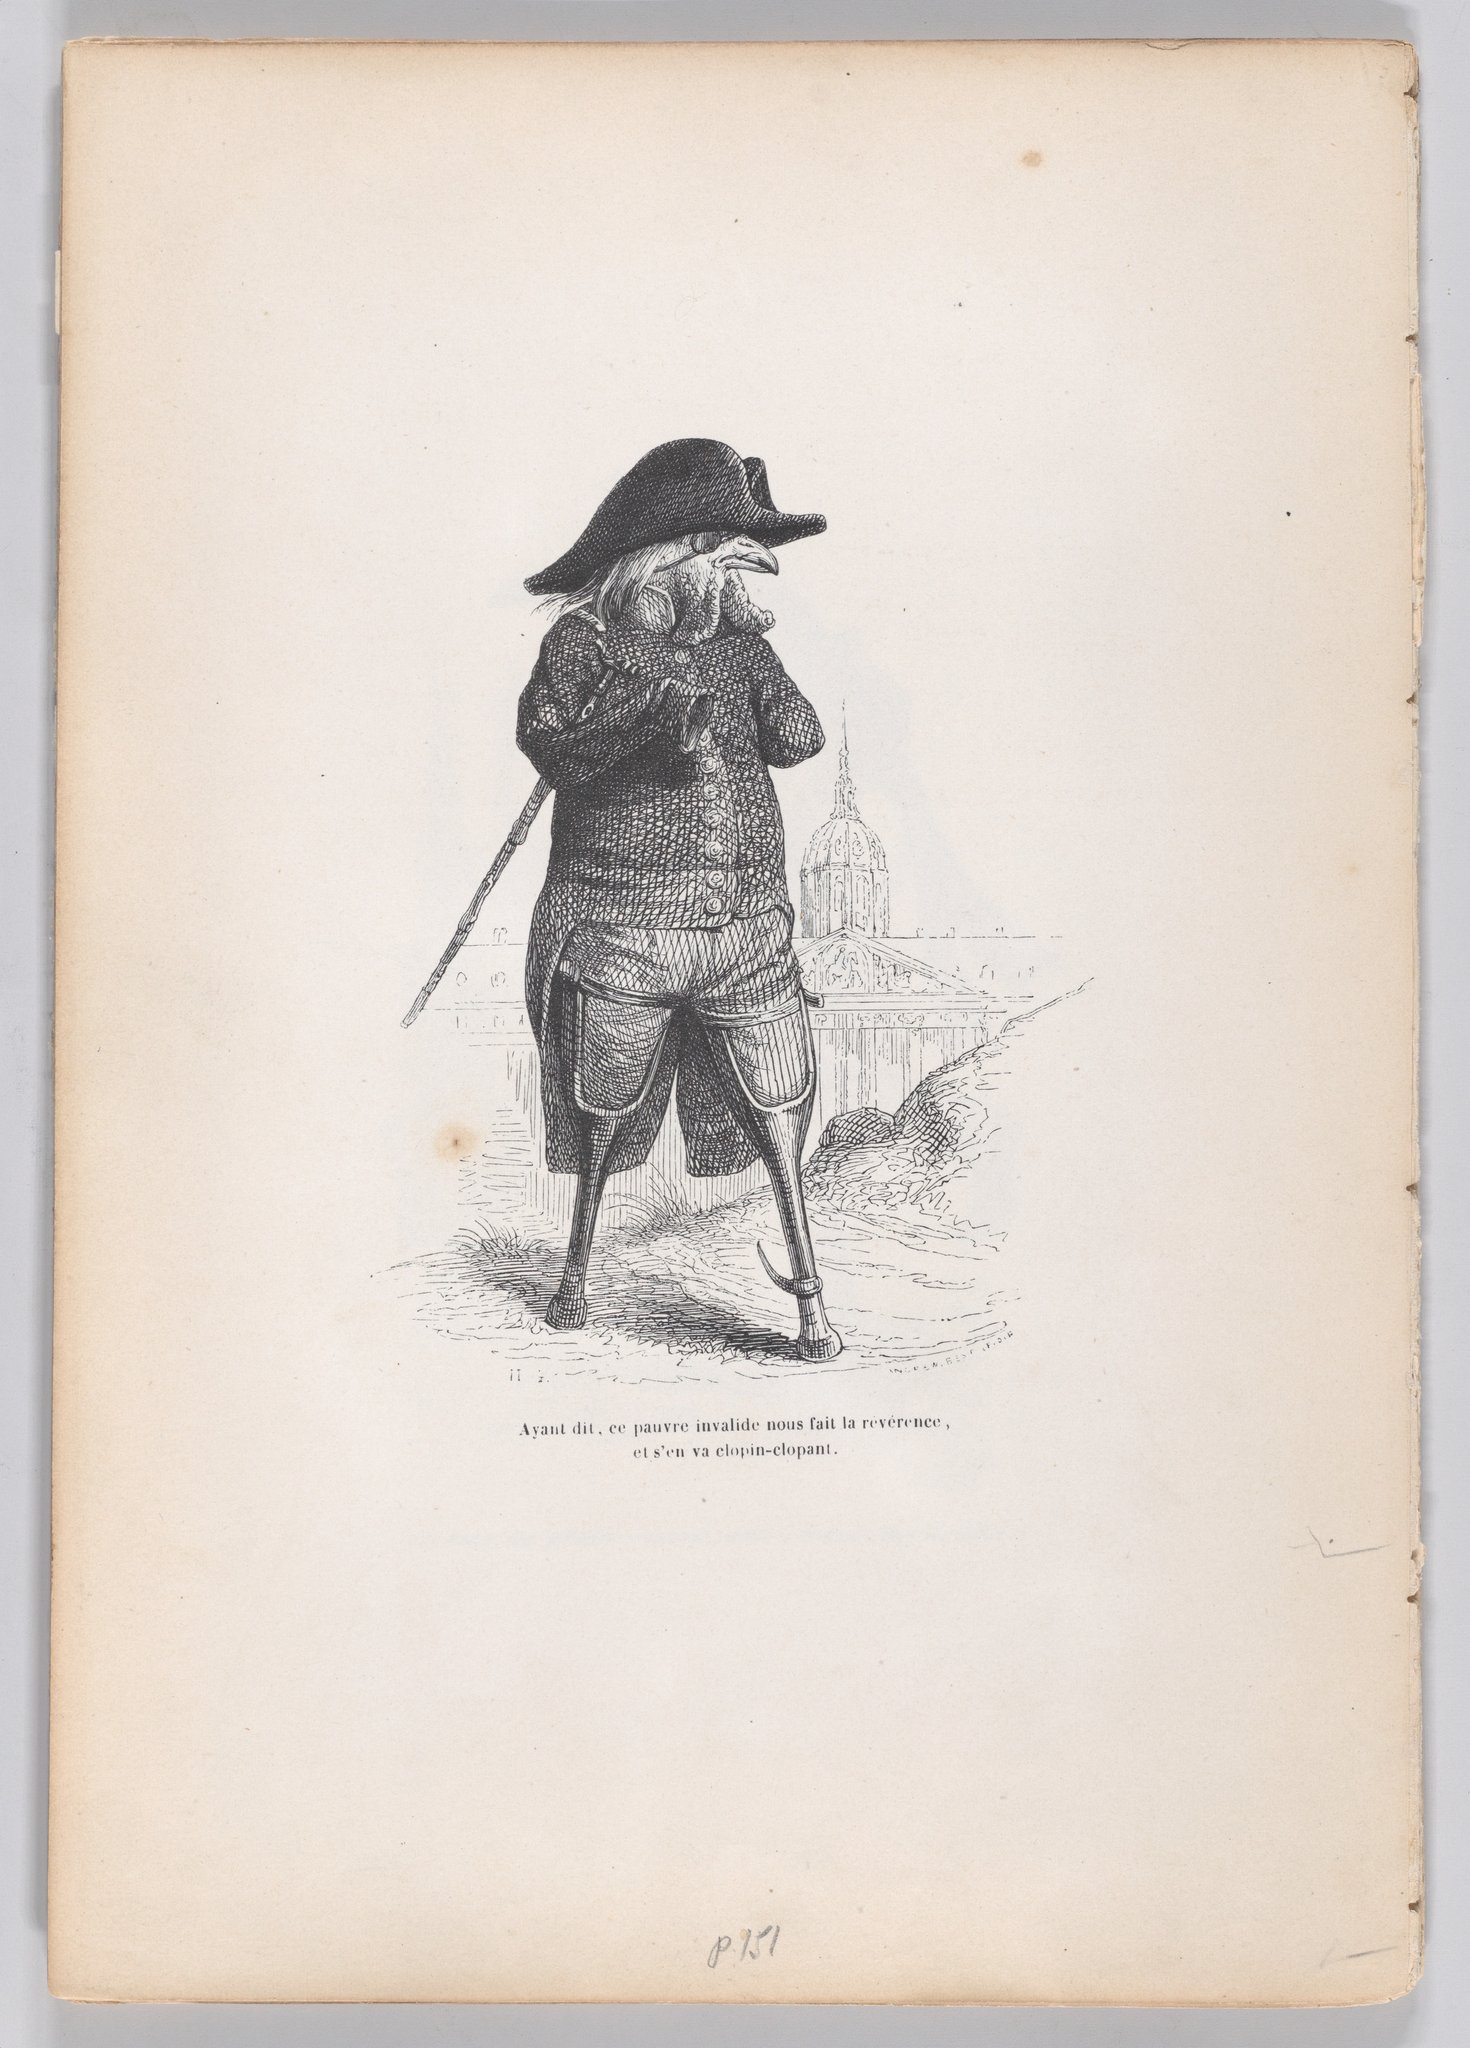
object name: print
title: Having said that, this poor invalid gives us a curtsy, and goes hobbling off, from "Scenes from the Private and Public Life of Animals"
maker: j. j. grandville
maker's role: illustrator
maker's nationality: french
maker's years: 1803-1847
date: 1837-1847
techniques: engraving